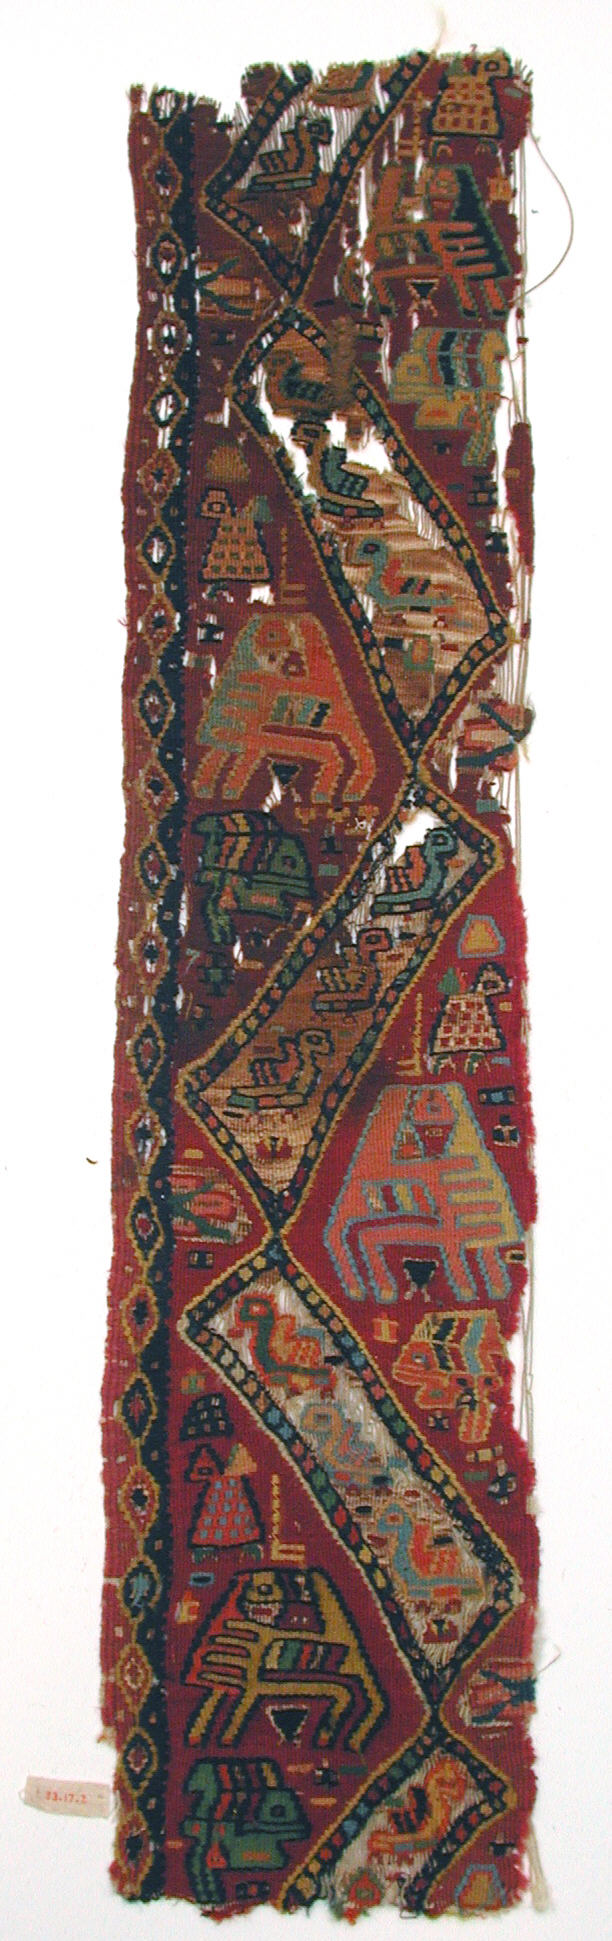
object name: textile fragment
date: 701-800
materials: linen, wool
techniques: weave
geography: egypt